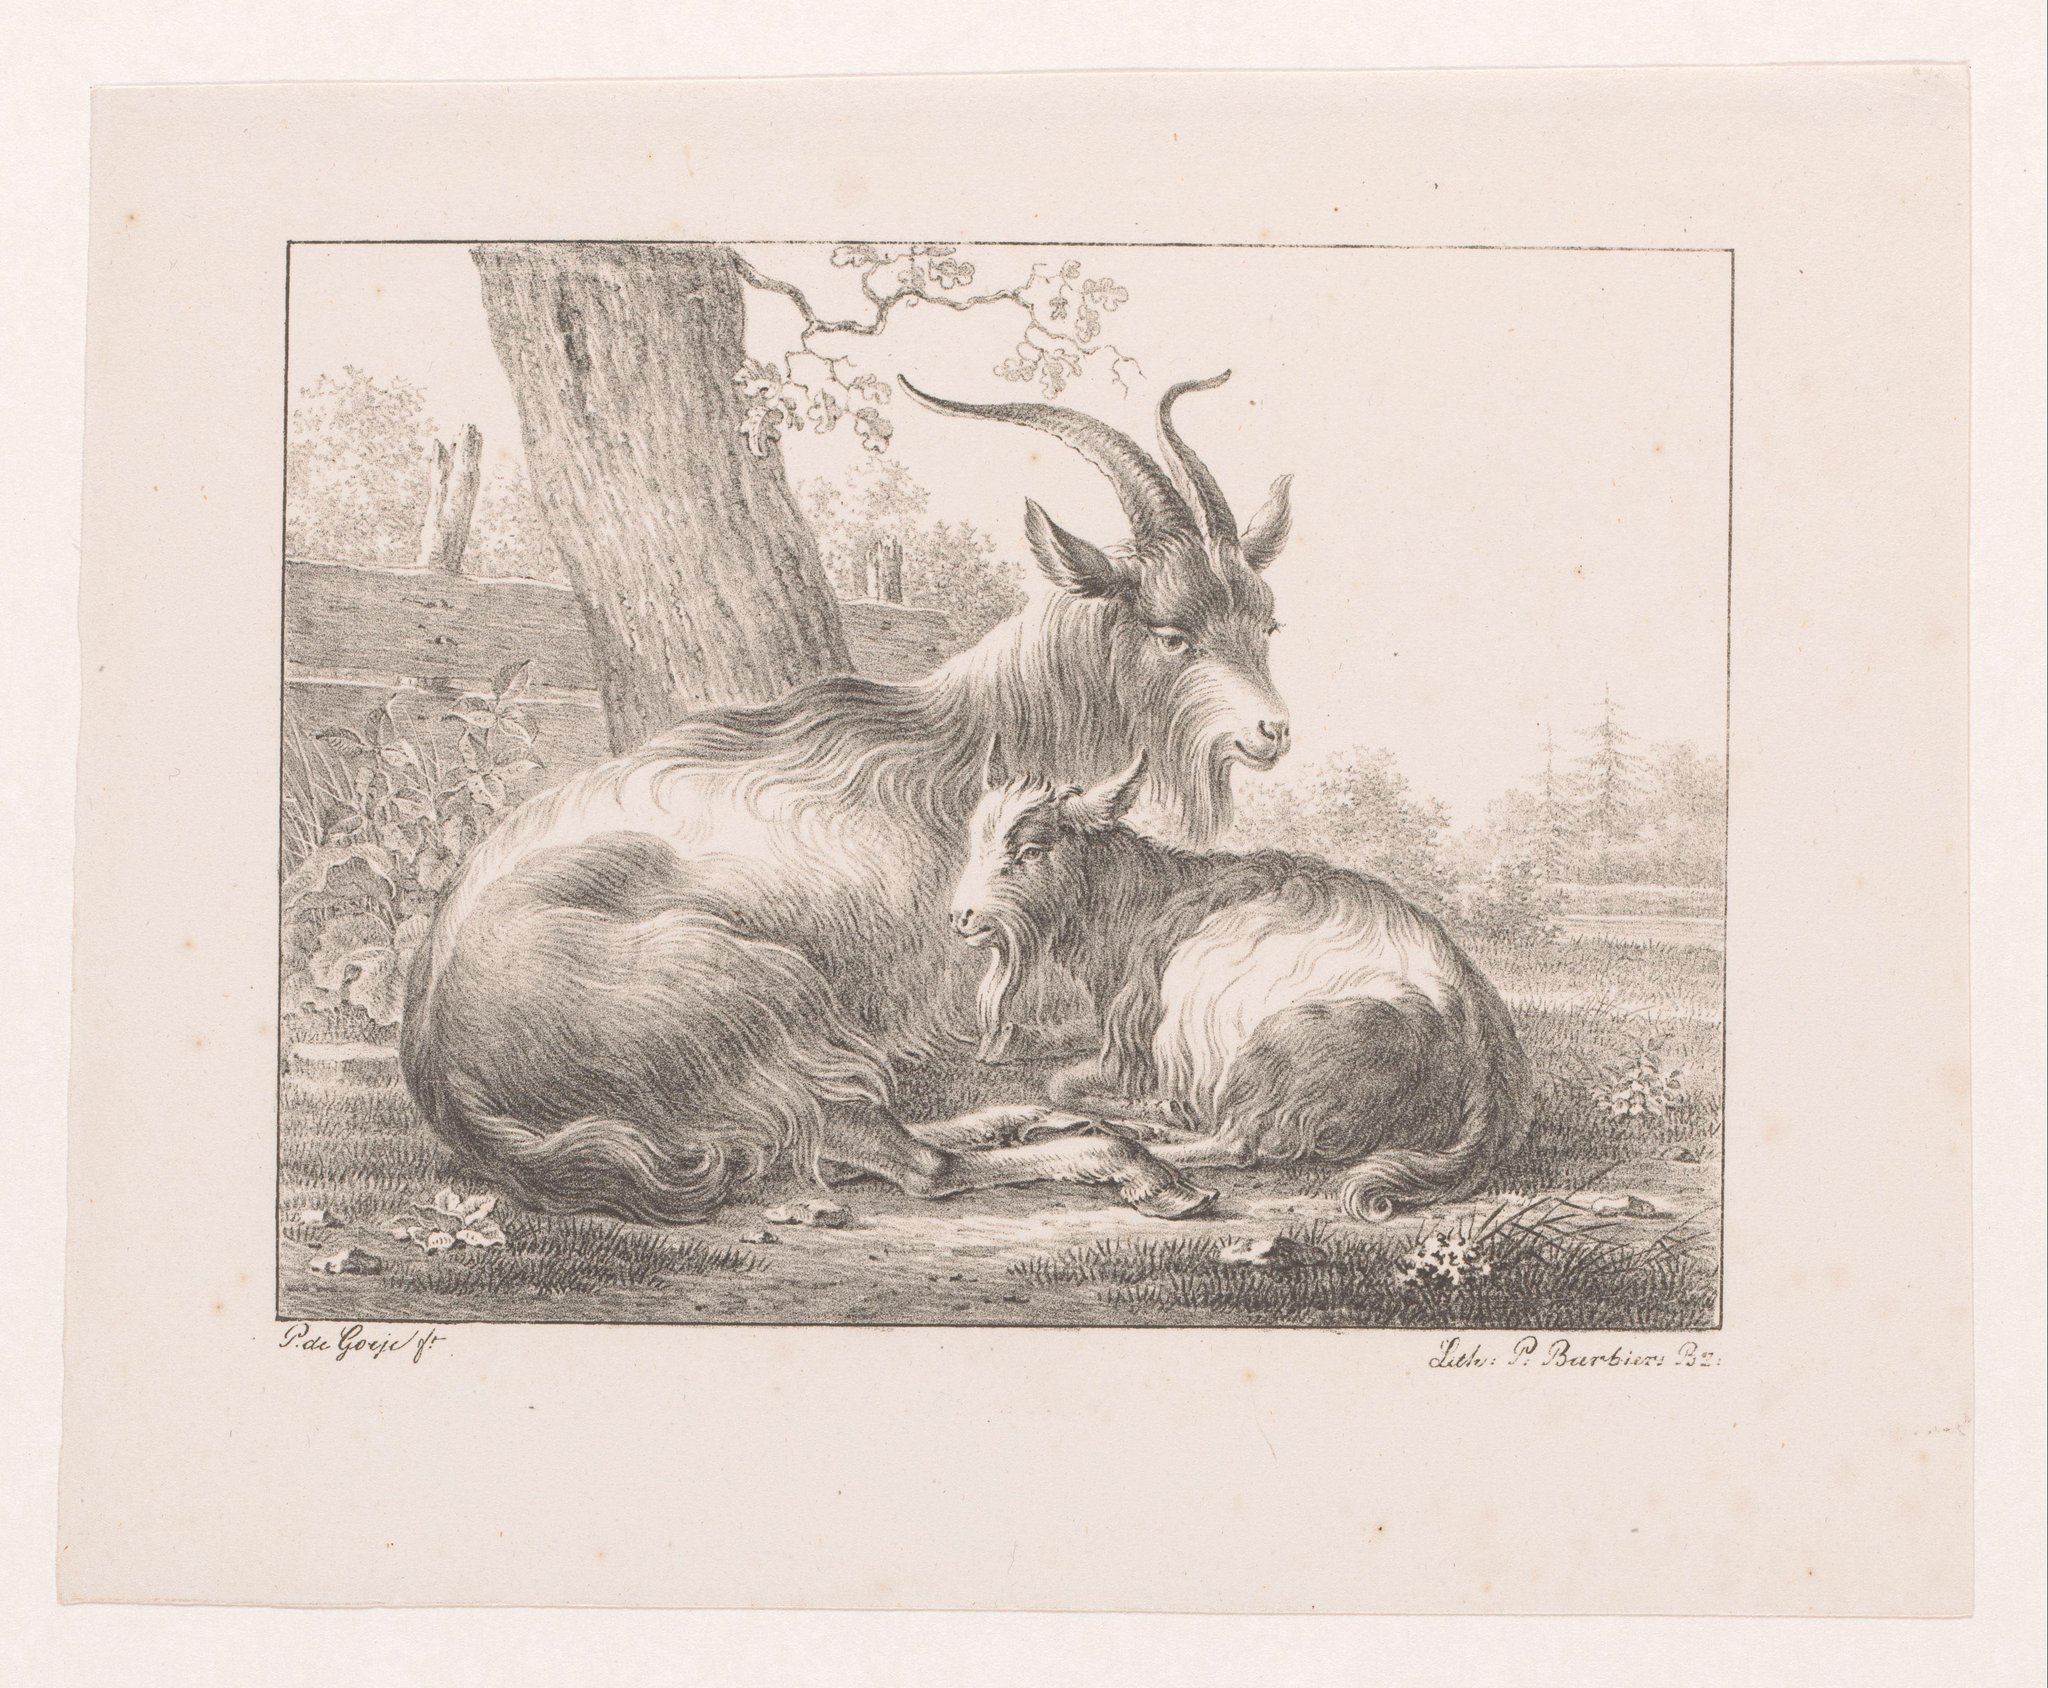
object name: print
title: Bok en geit in landschap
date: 1809-1837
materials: paper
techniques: lithograph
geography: netherlands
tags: fence, wall, paling, goat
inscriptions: collector's mark: Lugt 2228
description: De twee dieren liggen bij elkaar op de grond. Achter hen een houten hek en een boom.